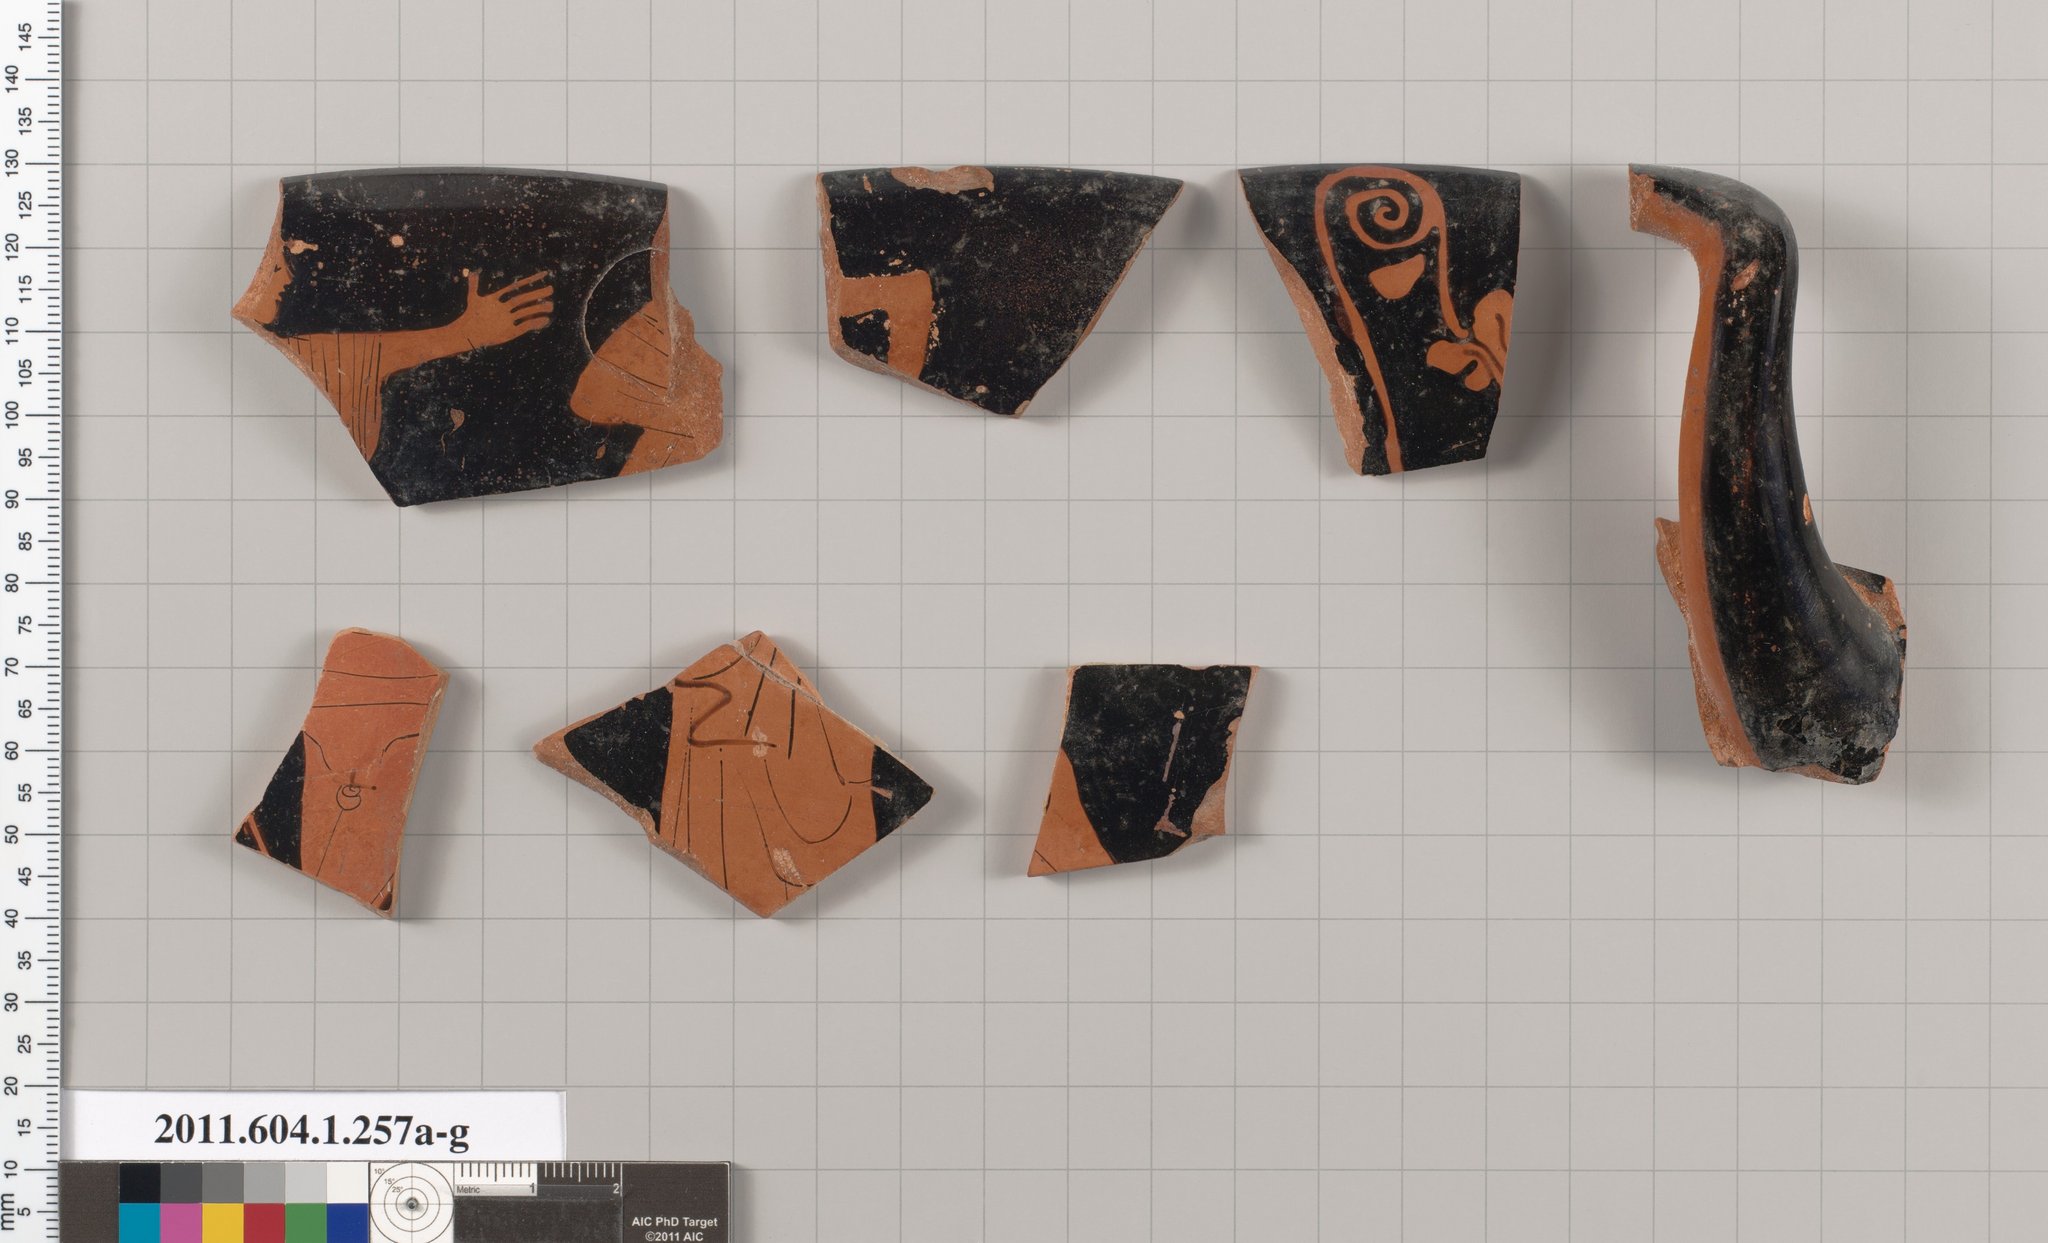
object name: kylix fragment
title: Terracotta fragments of a kylix (drinking cup)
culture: greek, attic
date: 475-451 BCE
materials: terracotta